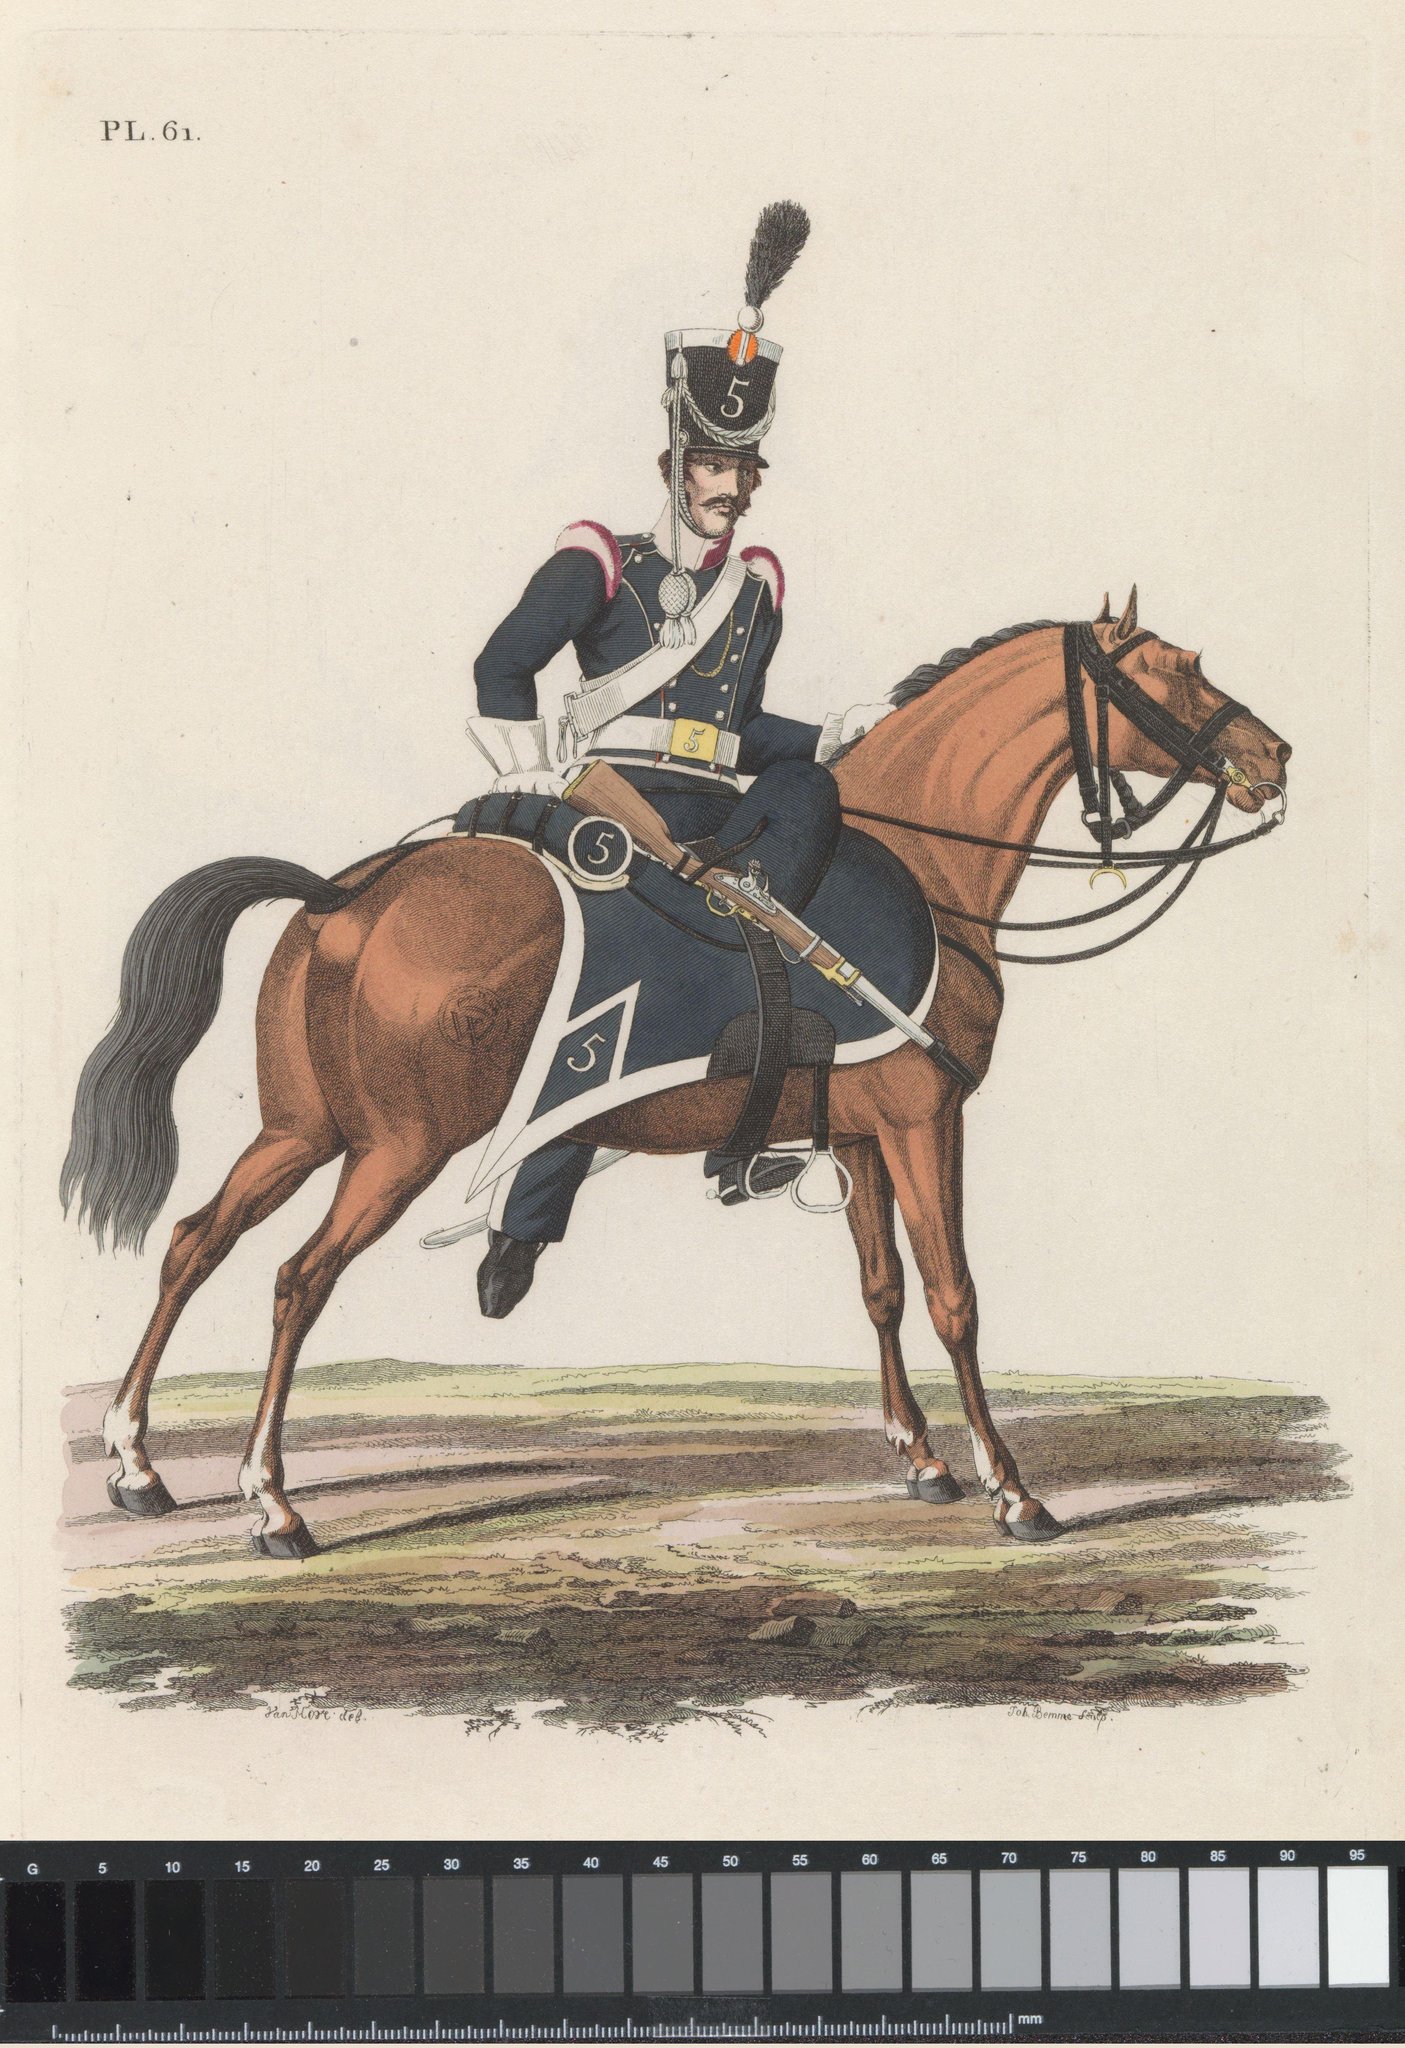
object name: costume print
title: Dragonder, te paard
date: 1826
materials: paper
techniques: engraving, etching, hand coloring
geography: netherlands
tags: (military) uniforms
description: Een Nederlandse dragonder van het Regiment Ligte Dragonders No 5, te paard. Plaat 61. Uniformvoorstelling in 'Vervolg van de Beschrijving hoedanig de Koninklijke Nederlandsche troepen' van J.F. Teupken, 1826.